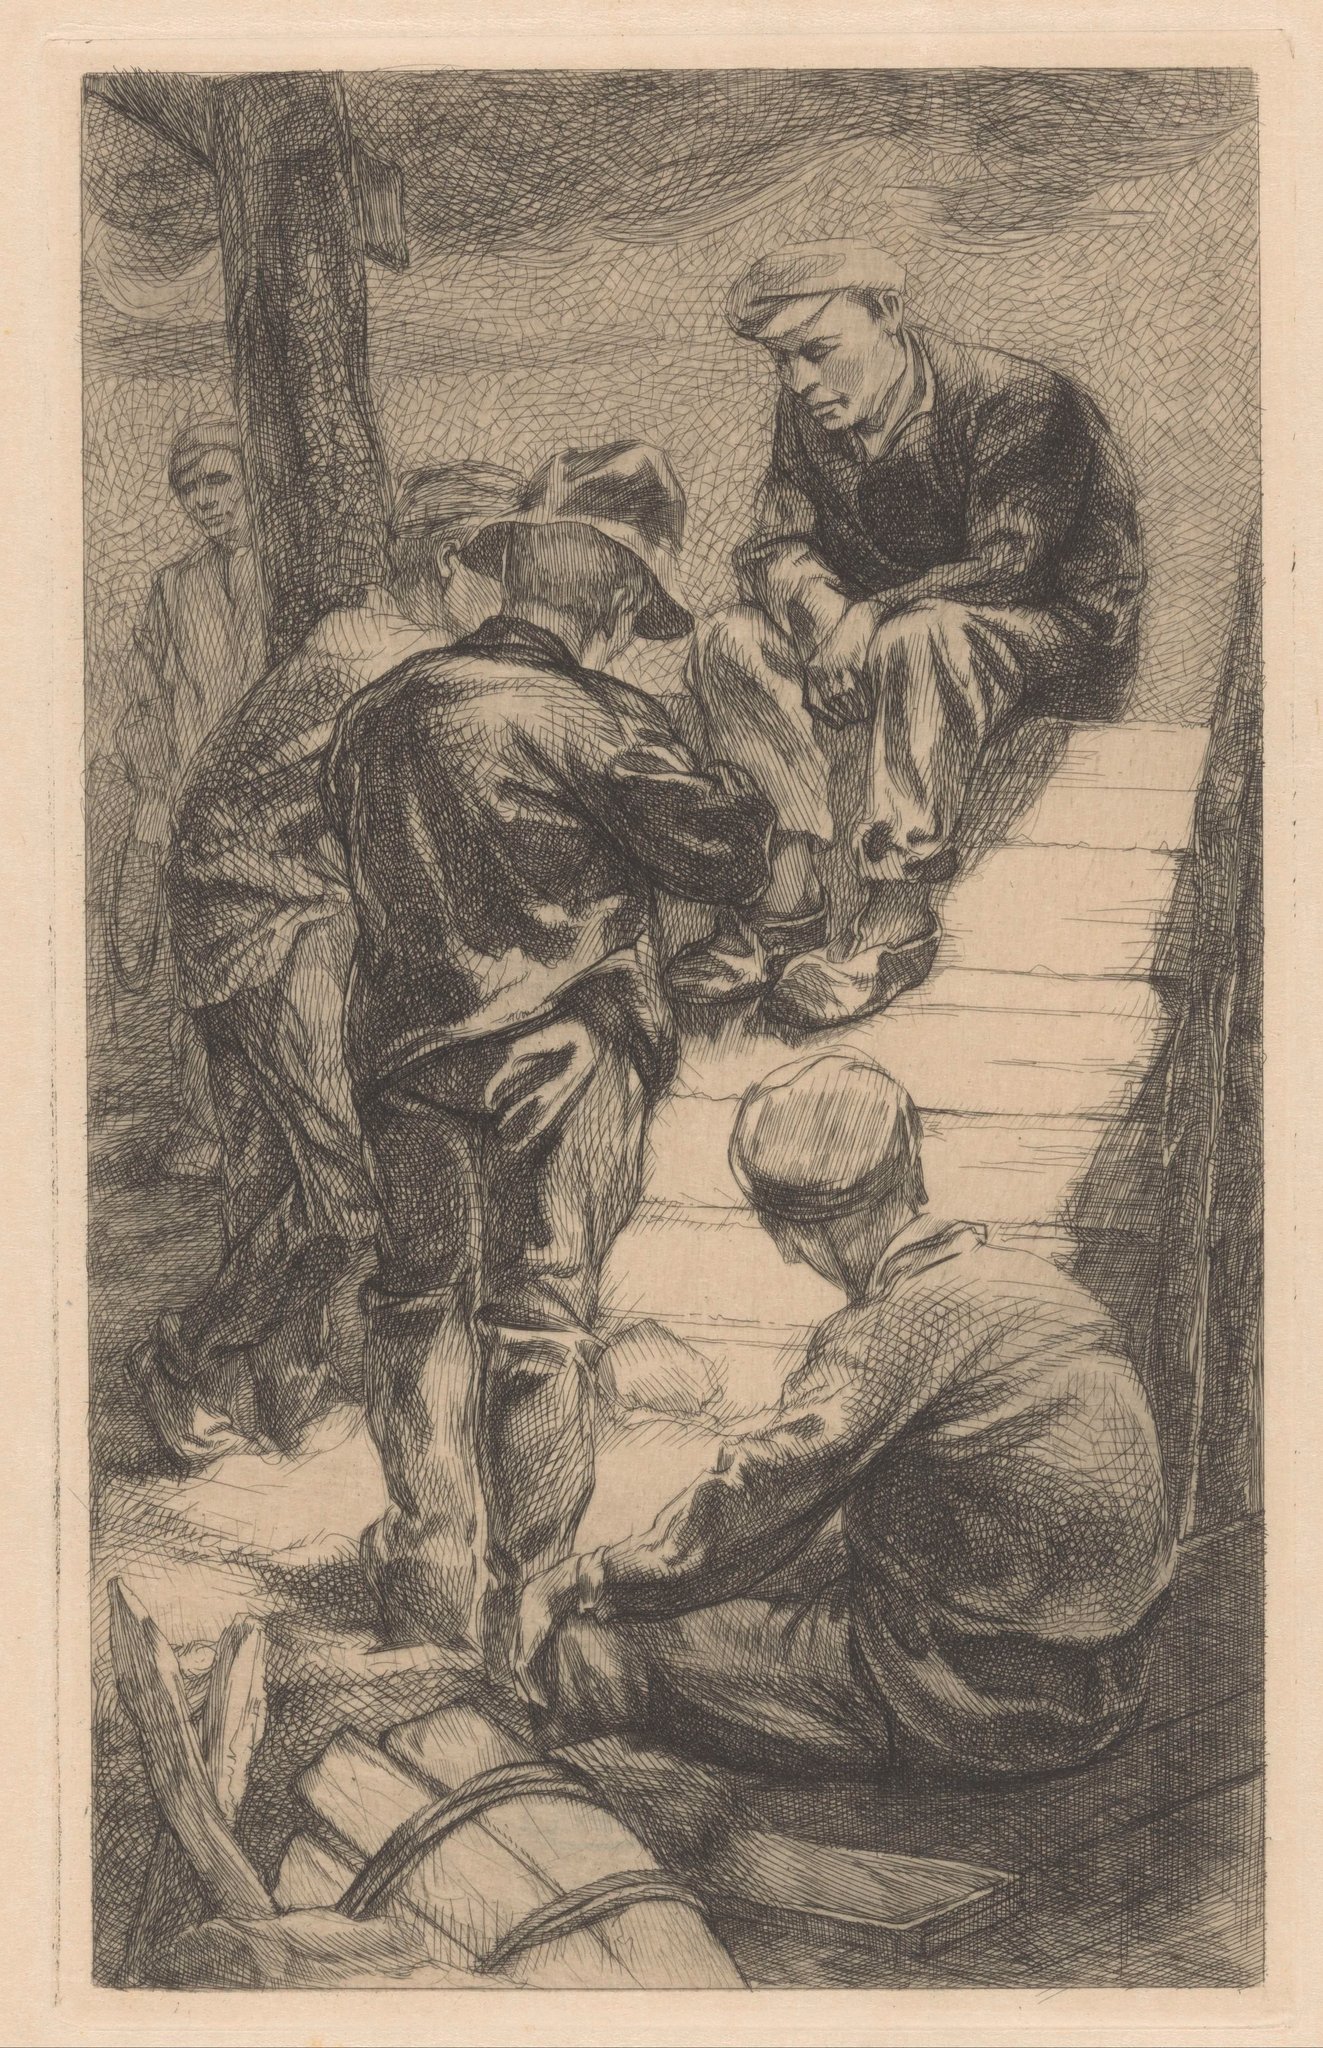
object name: print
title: Vijf arbeiders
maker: johannes josephus aarts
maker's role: draughtsman, print maker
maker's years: 1871-1934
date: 1881-1934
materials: paper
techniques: etching, intaglio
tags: working class, labourers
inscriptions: collector's mark: Lugt 2228, collector's mark: Lugt 2760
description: Een groep van vijf werklieden rondom en op een houten loopplank.